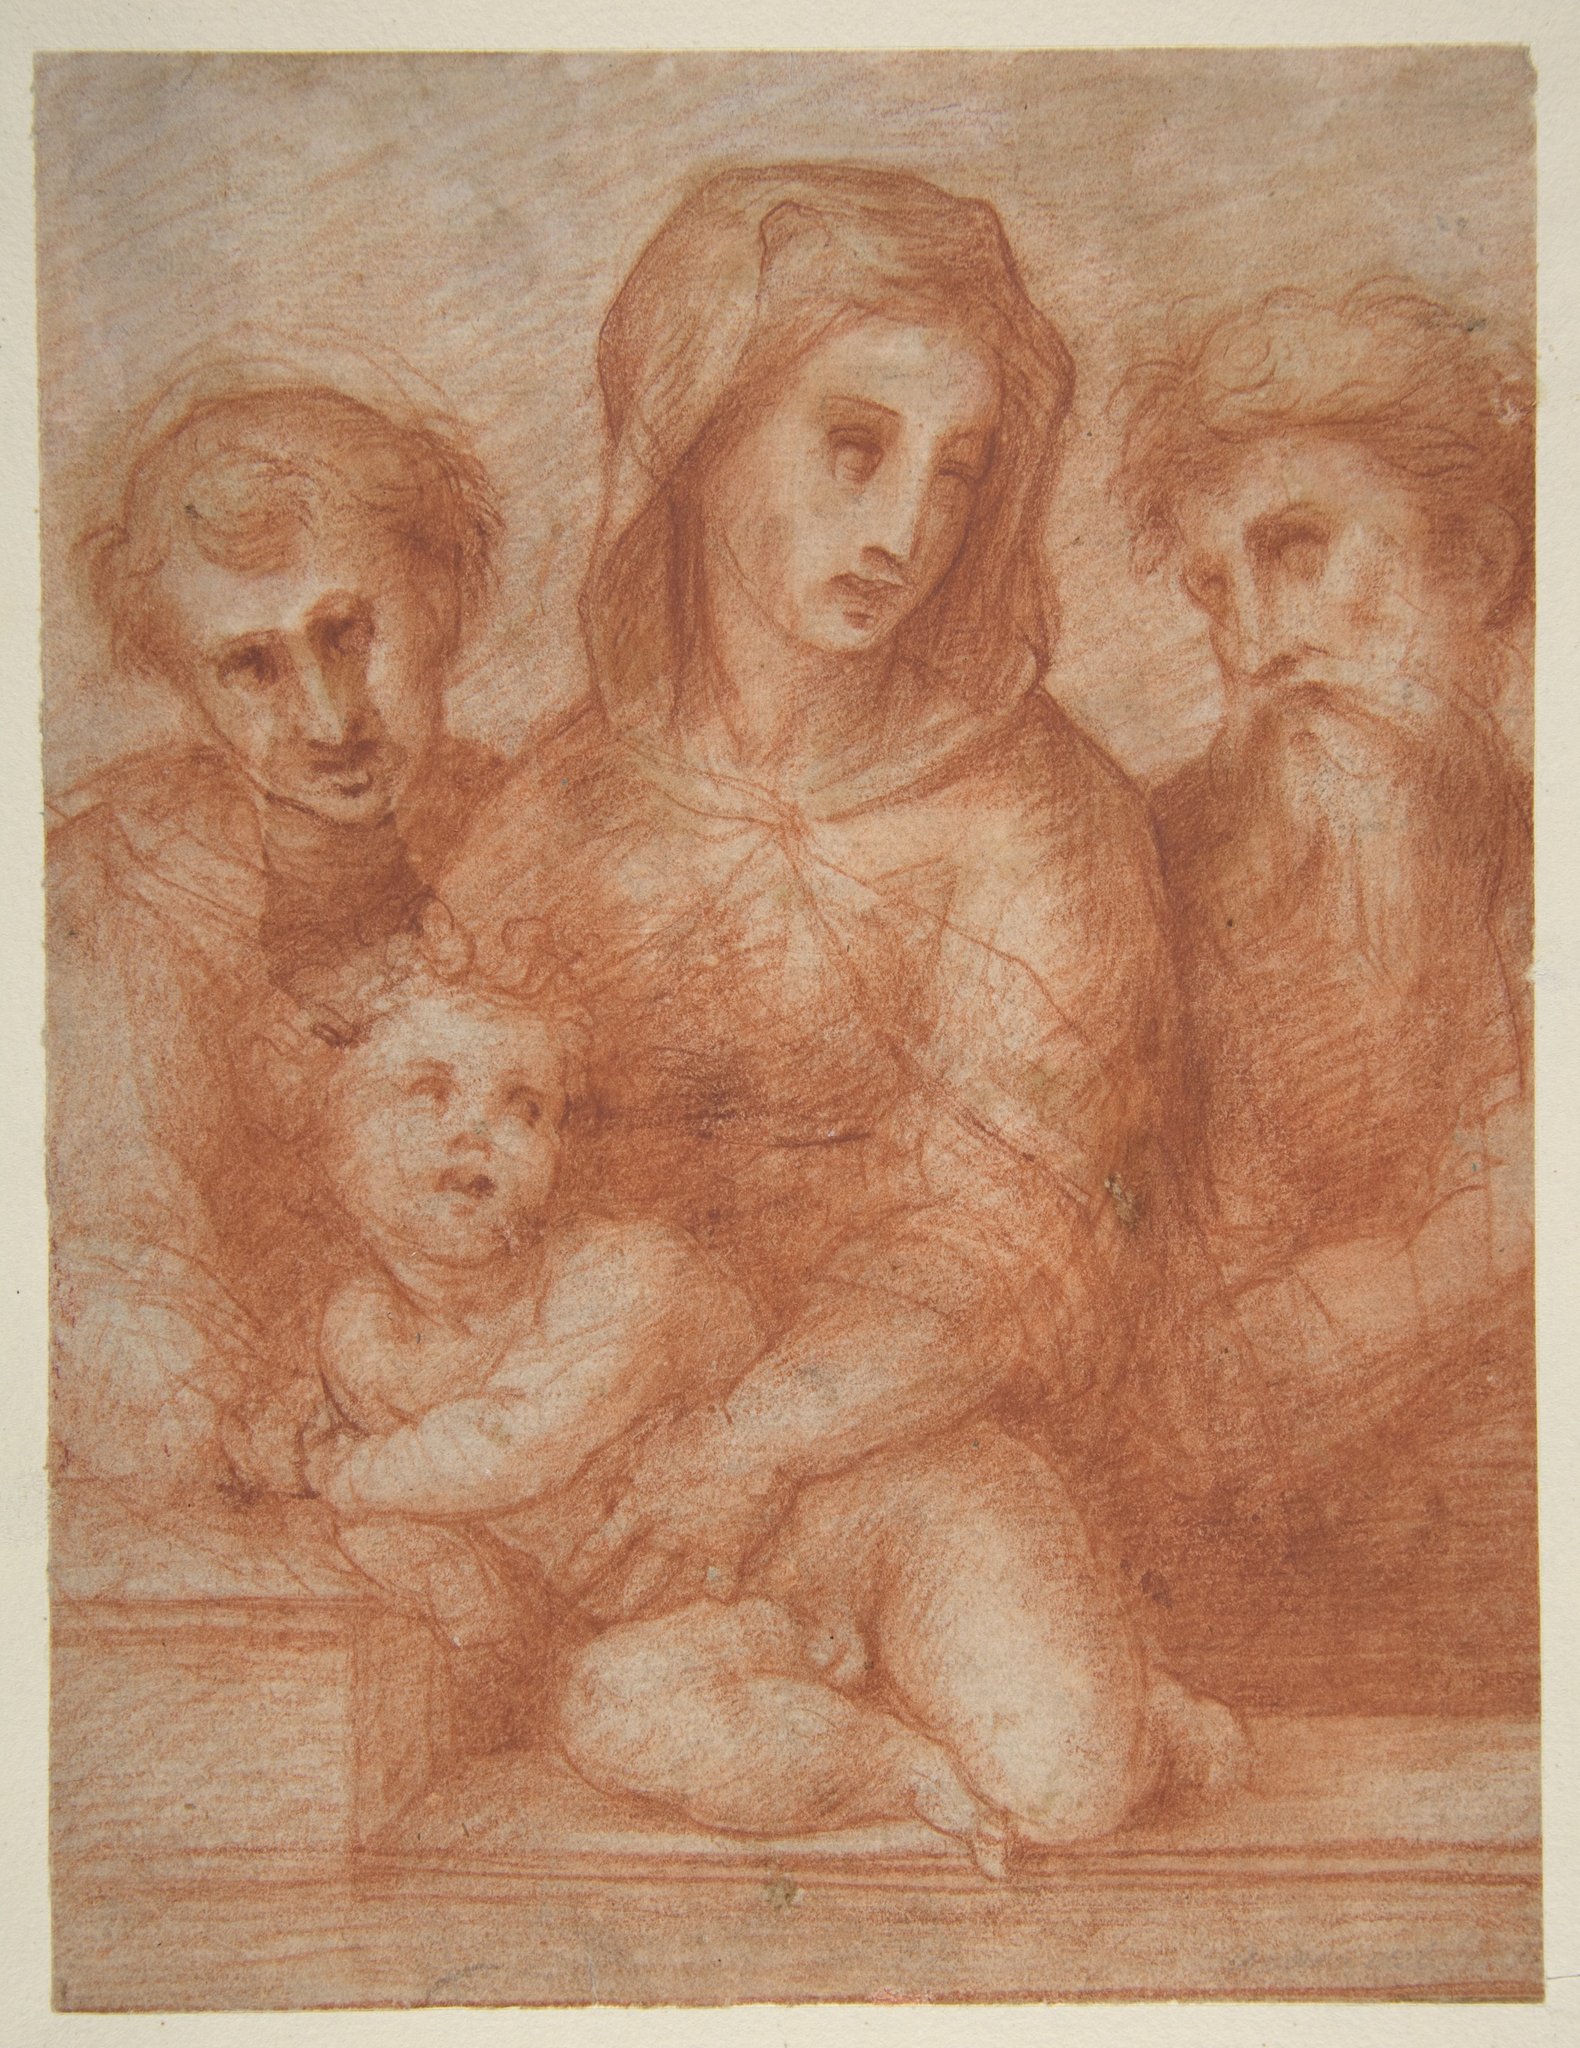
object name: drawing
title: Virgin and Child with Two Saints (recto); Fragmentary Design of a Pietà (verso)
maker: domenico puligo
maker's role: artist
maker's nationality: italian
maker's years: 1492-1527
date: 1515-1520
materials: chalk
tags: madonna and child,saints